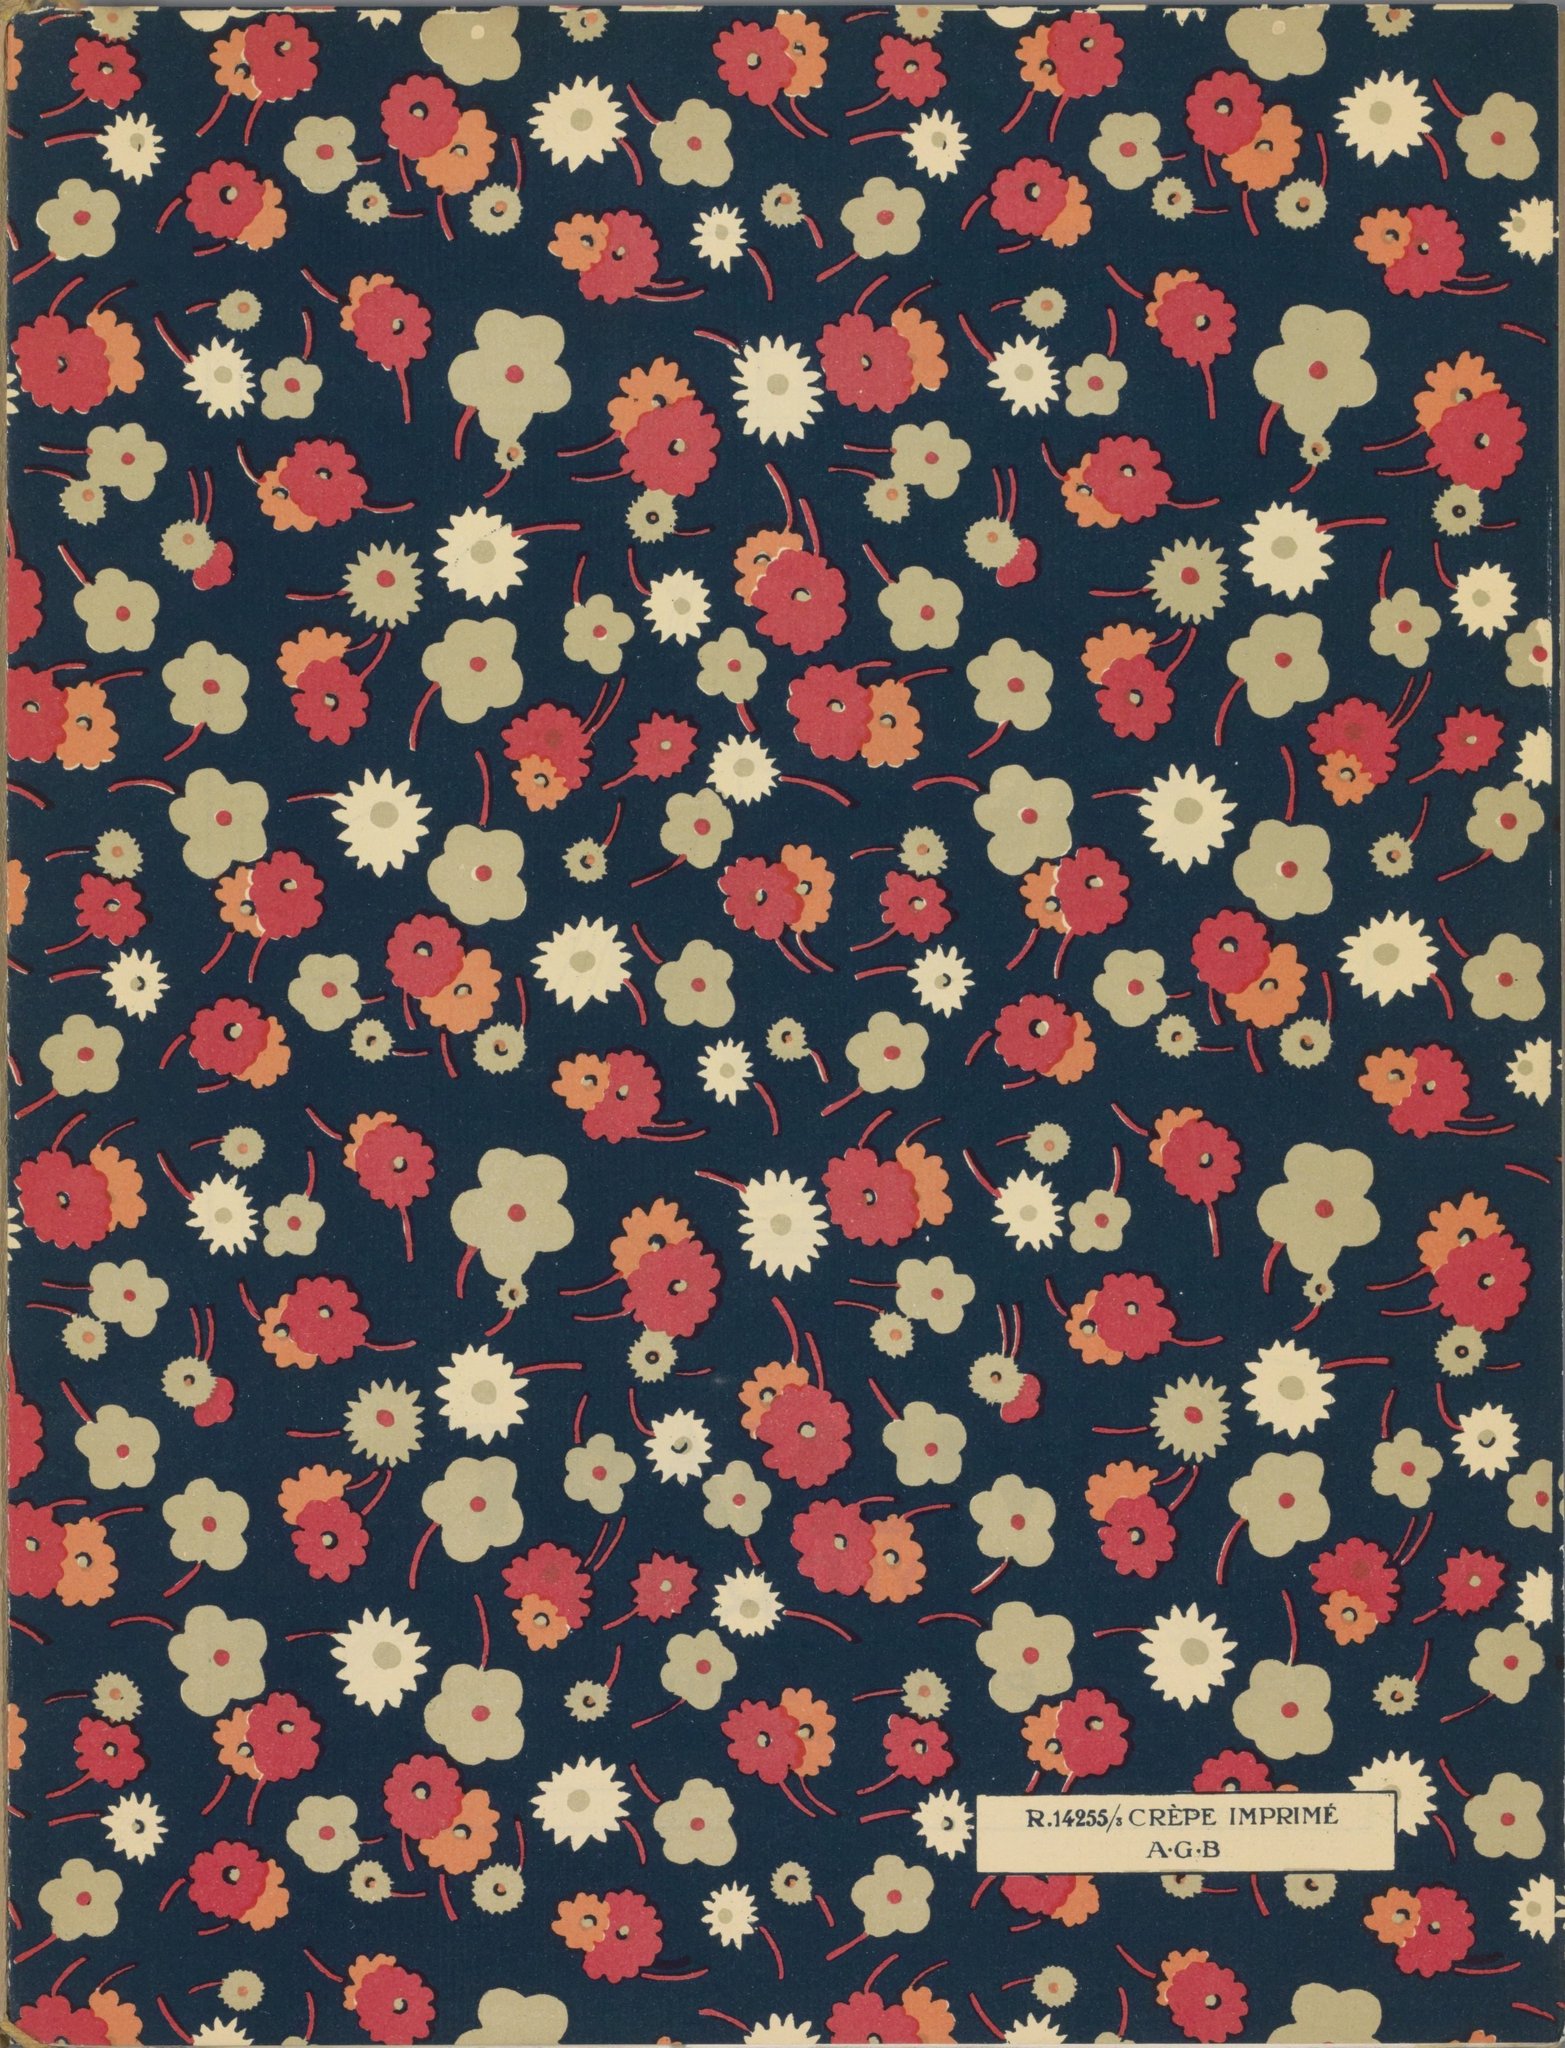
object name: magazine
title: Art - Goût - Beauté, Feuillets de l' élégance féminine, Juin 1929, No. 106, 9e Année, p.1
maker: charles goy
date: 1929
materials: paper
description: Schutblad: patroon van witte, grijze, roze en rode bloemen op donkerblauw fond. Rechtsonder in kader: R. 14255/3 Crêpe de Chine imprimé A.G.B.